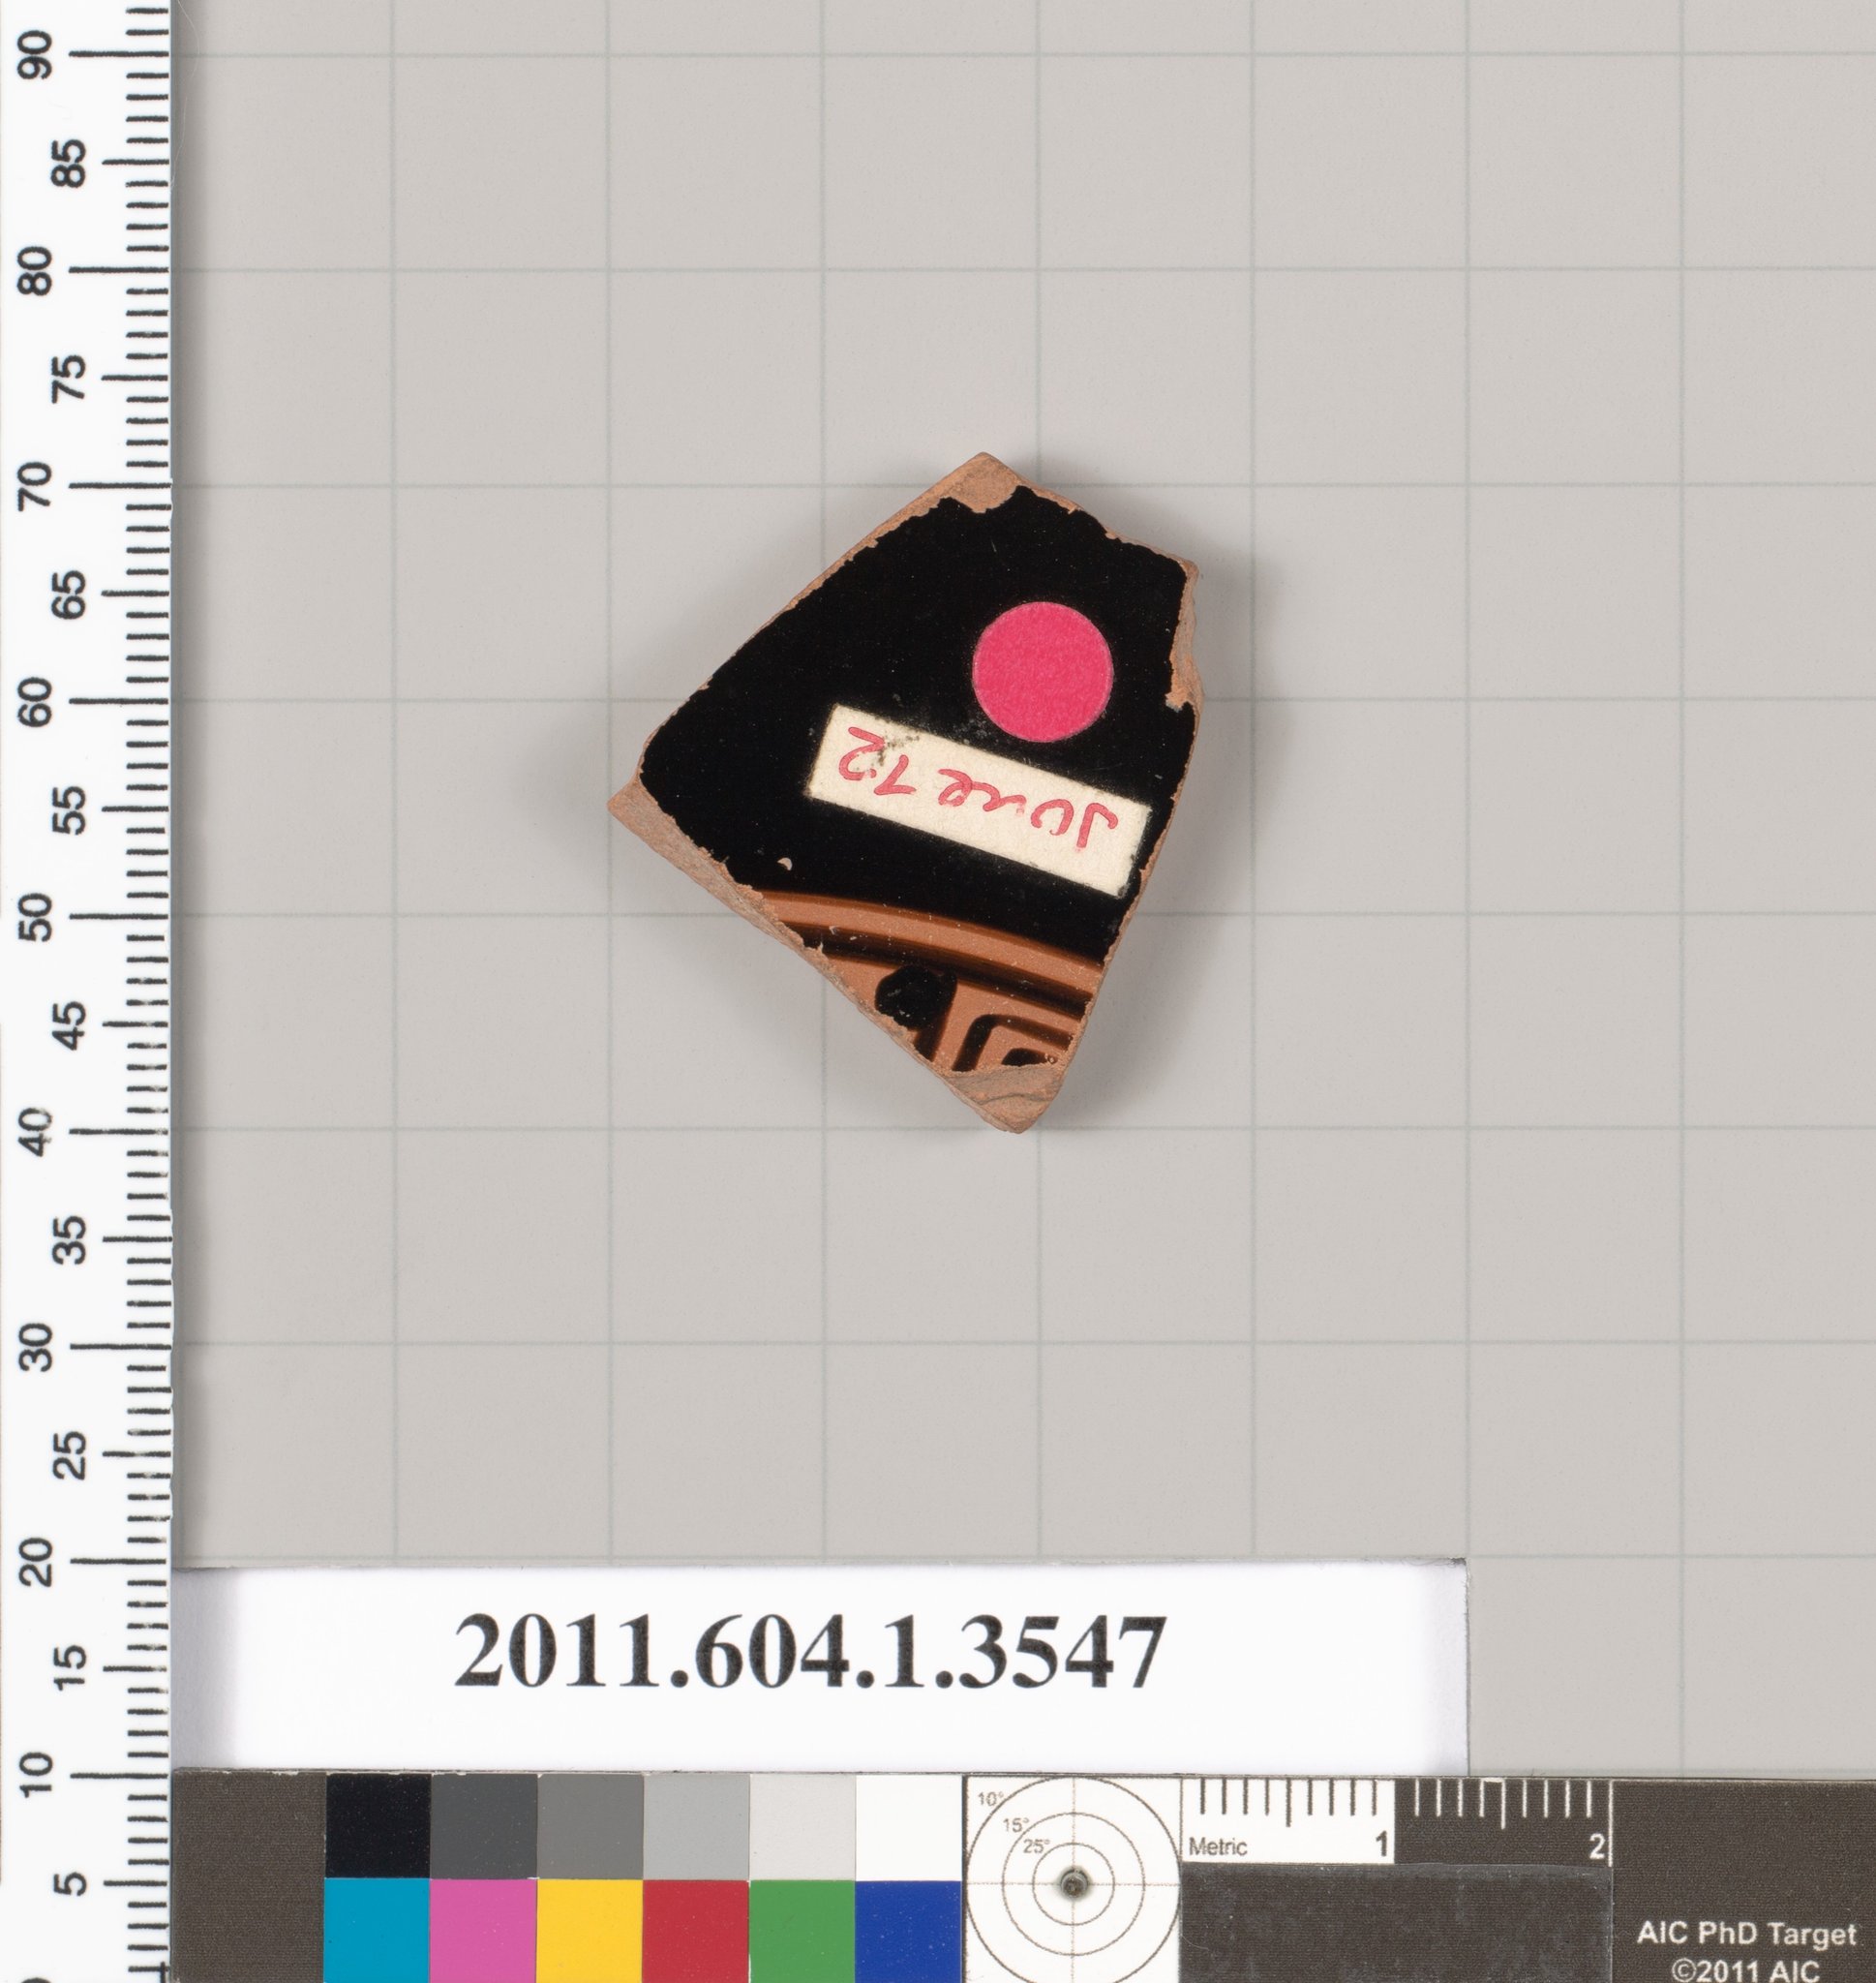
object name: kylix fragment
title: Terracotta fragment of a kylix (drinking cup)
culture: greek, attic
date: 490-470 BCE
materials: terracotta